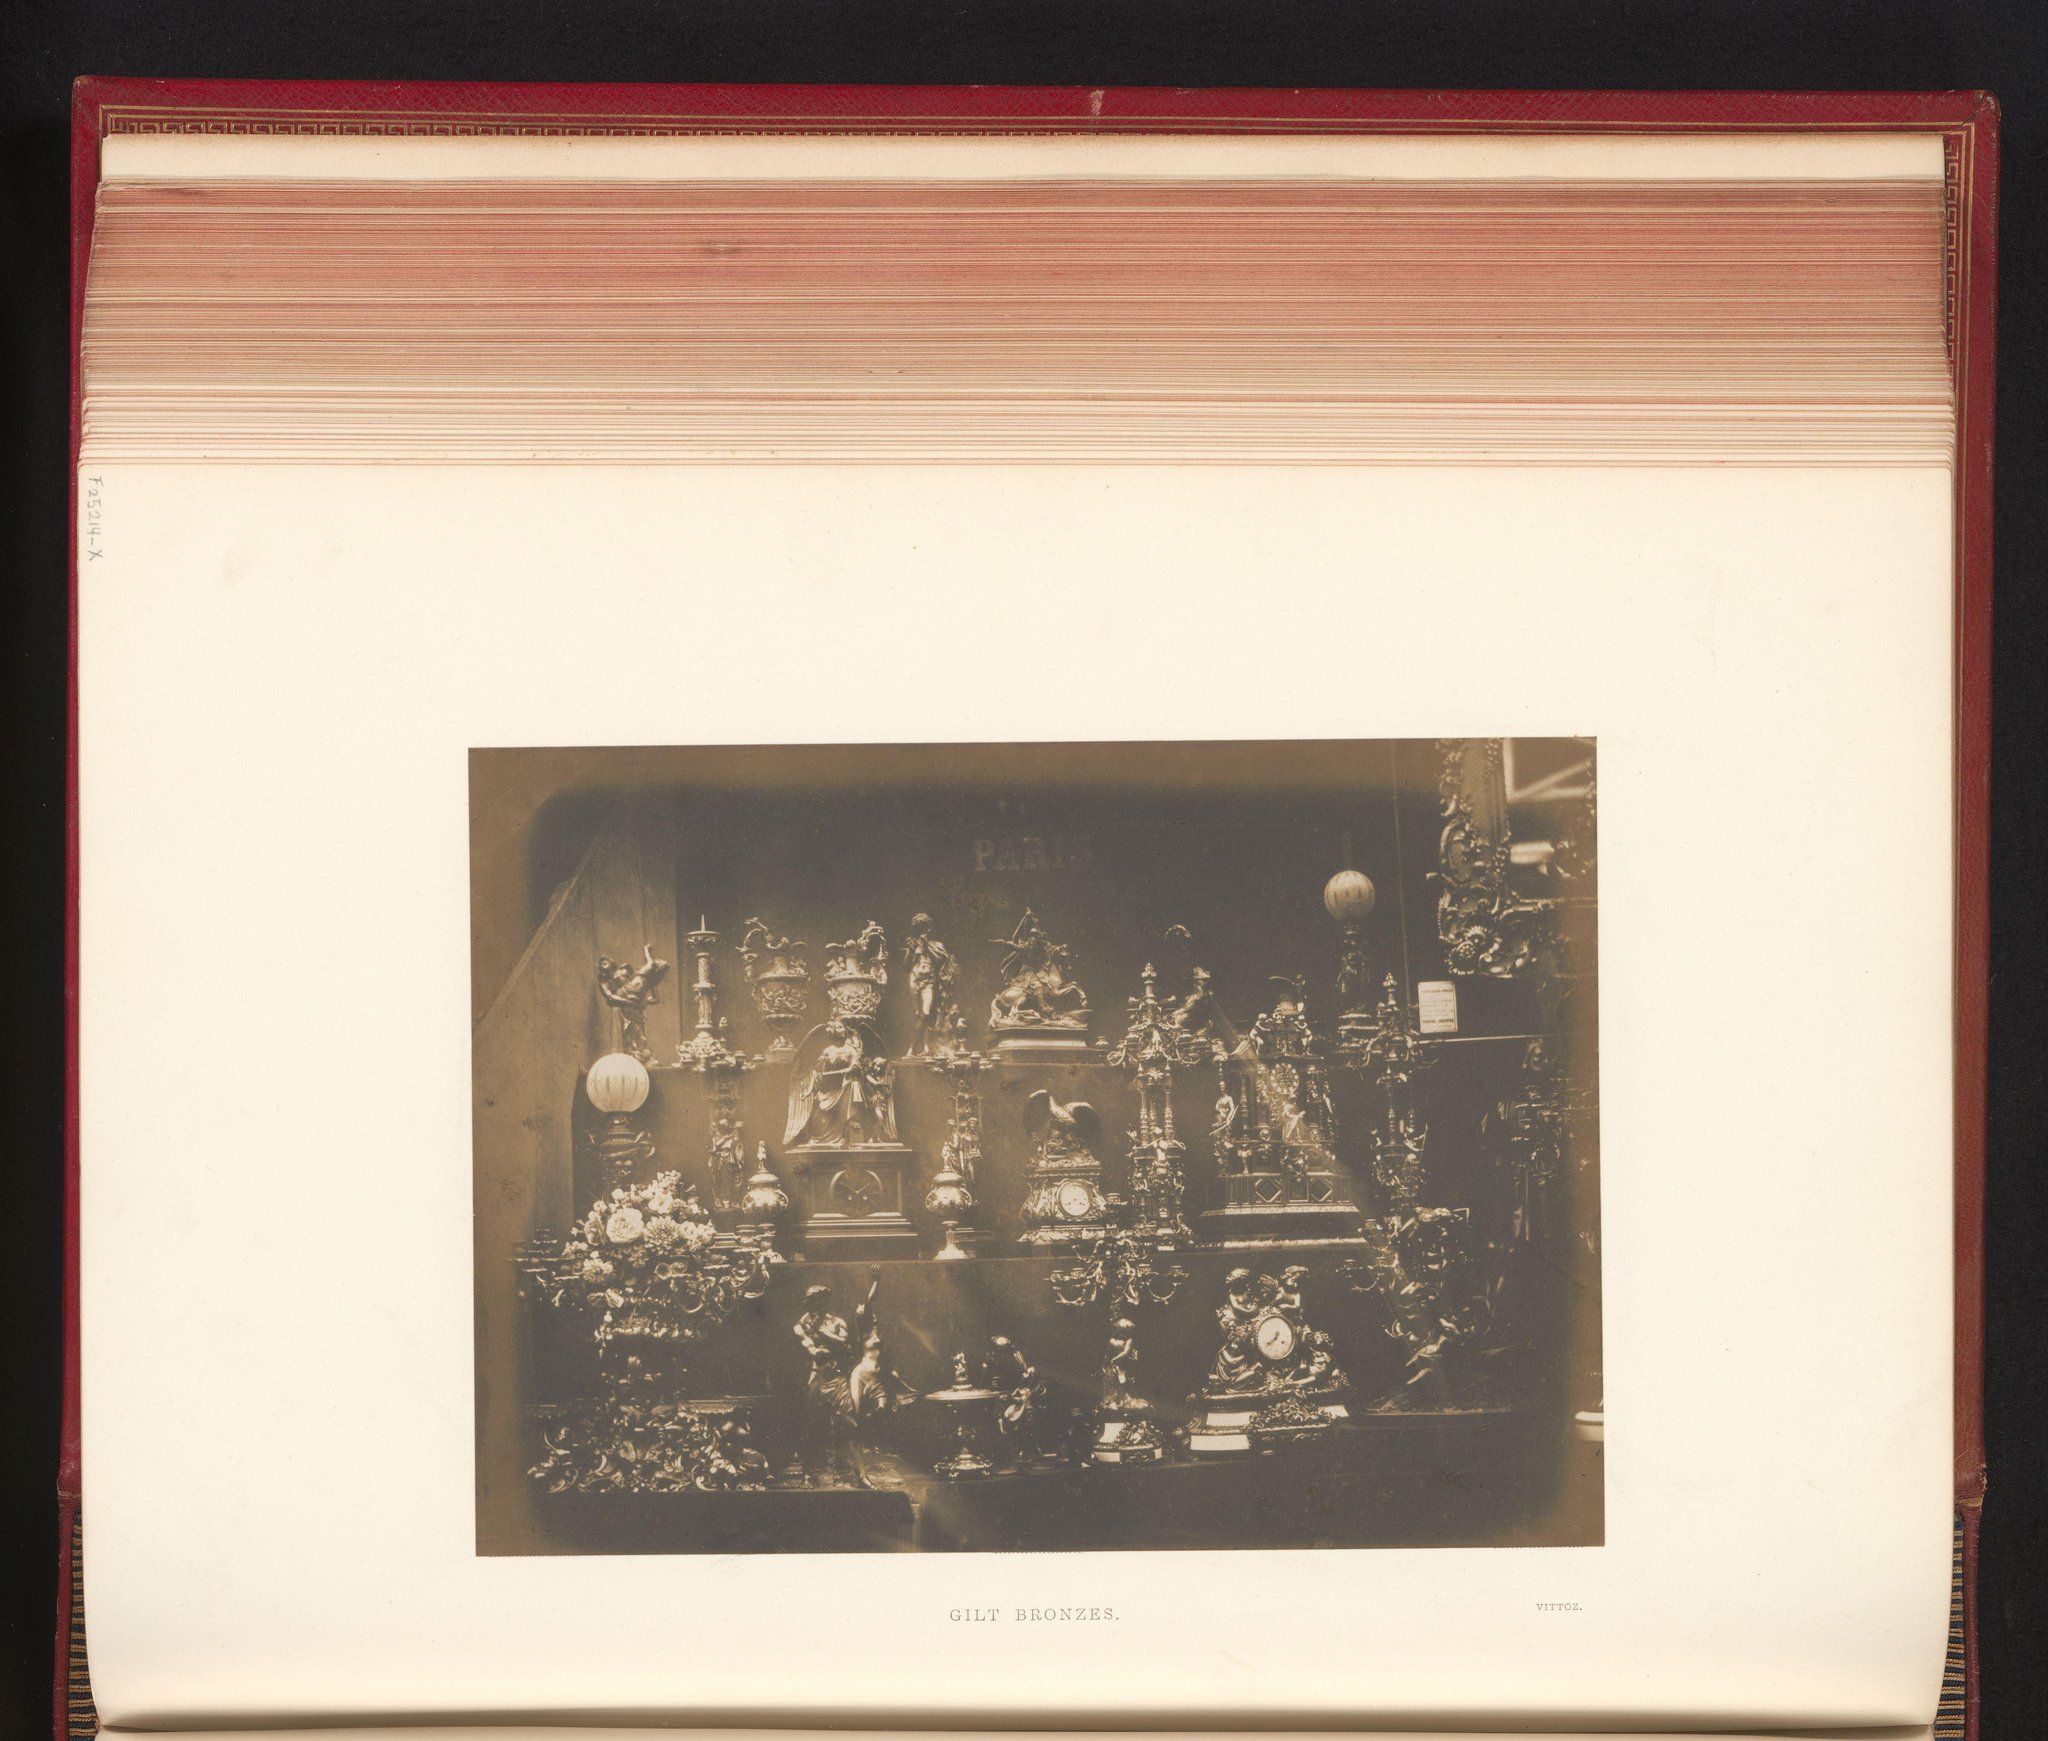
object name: photograph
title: Gilt Bronzes. Vittoz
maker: Anonymous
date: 1851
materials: photographic support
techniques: salted paper print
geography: london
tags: piece of sculpture, reproduction of a piece of sculpture, london